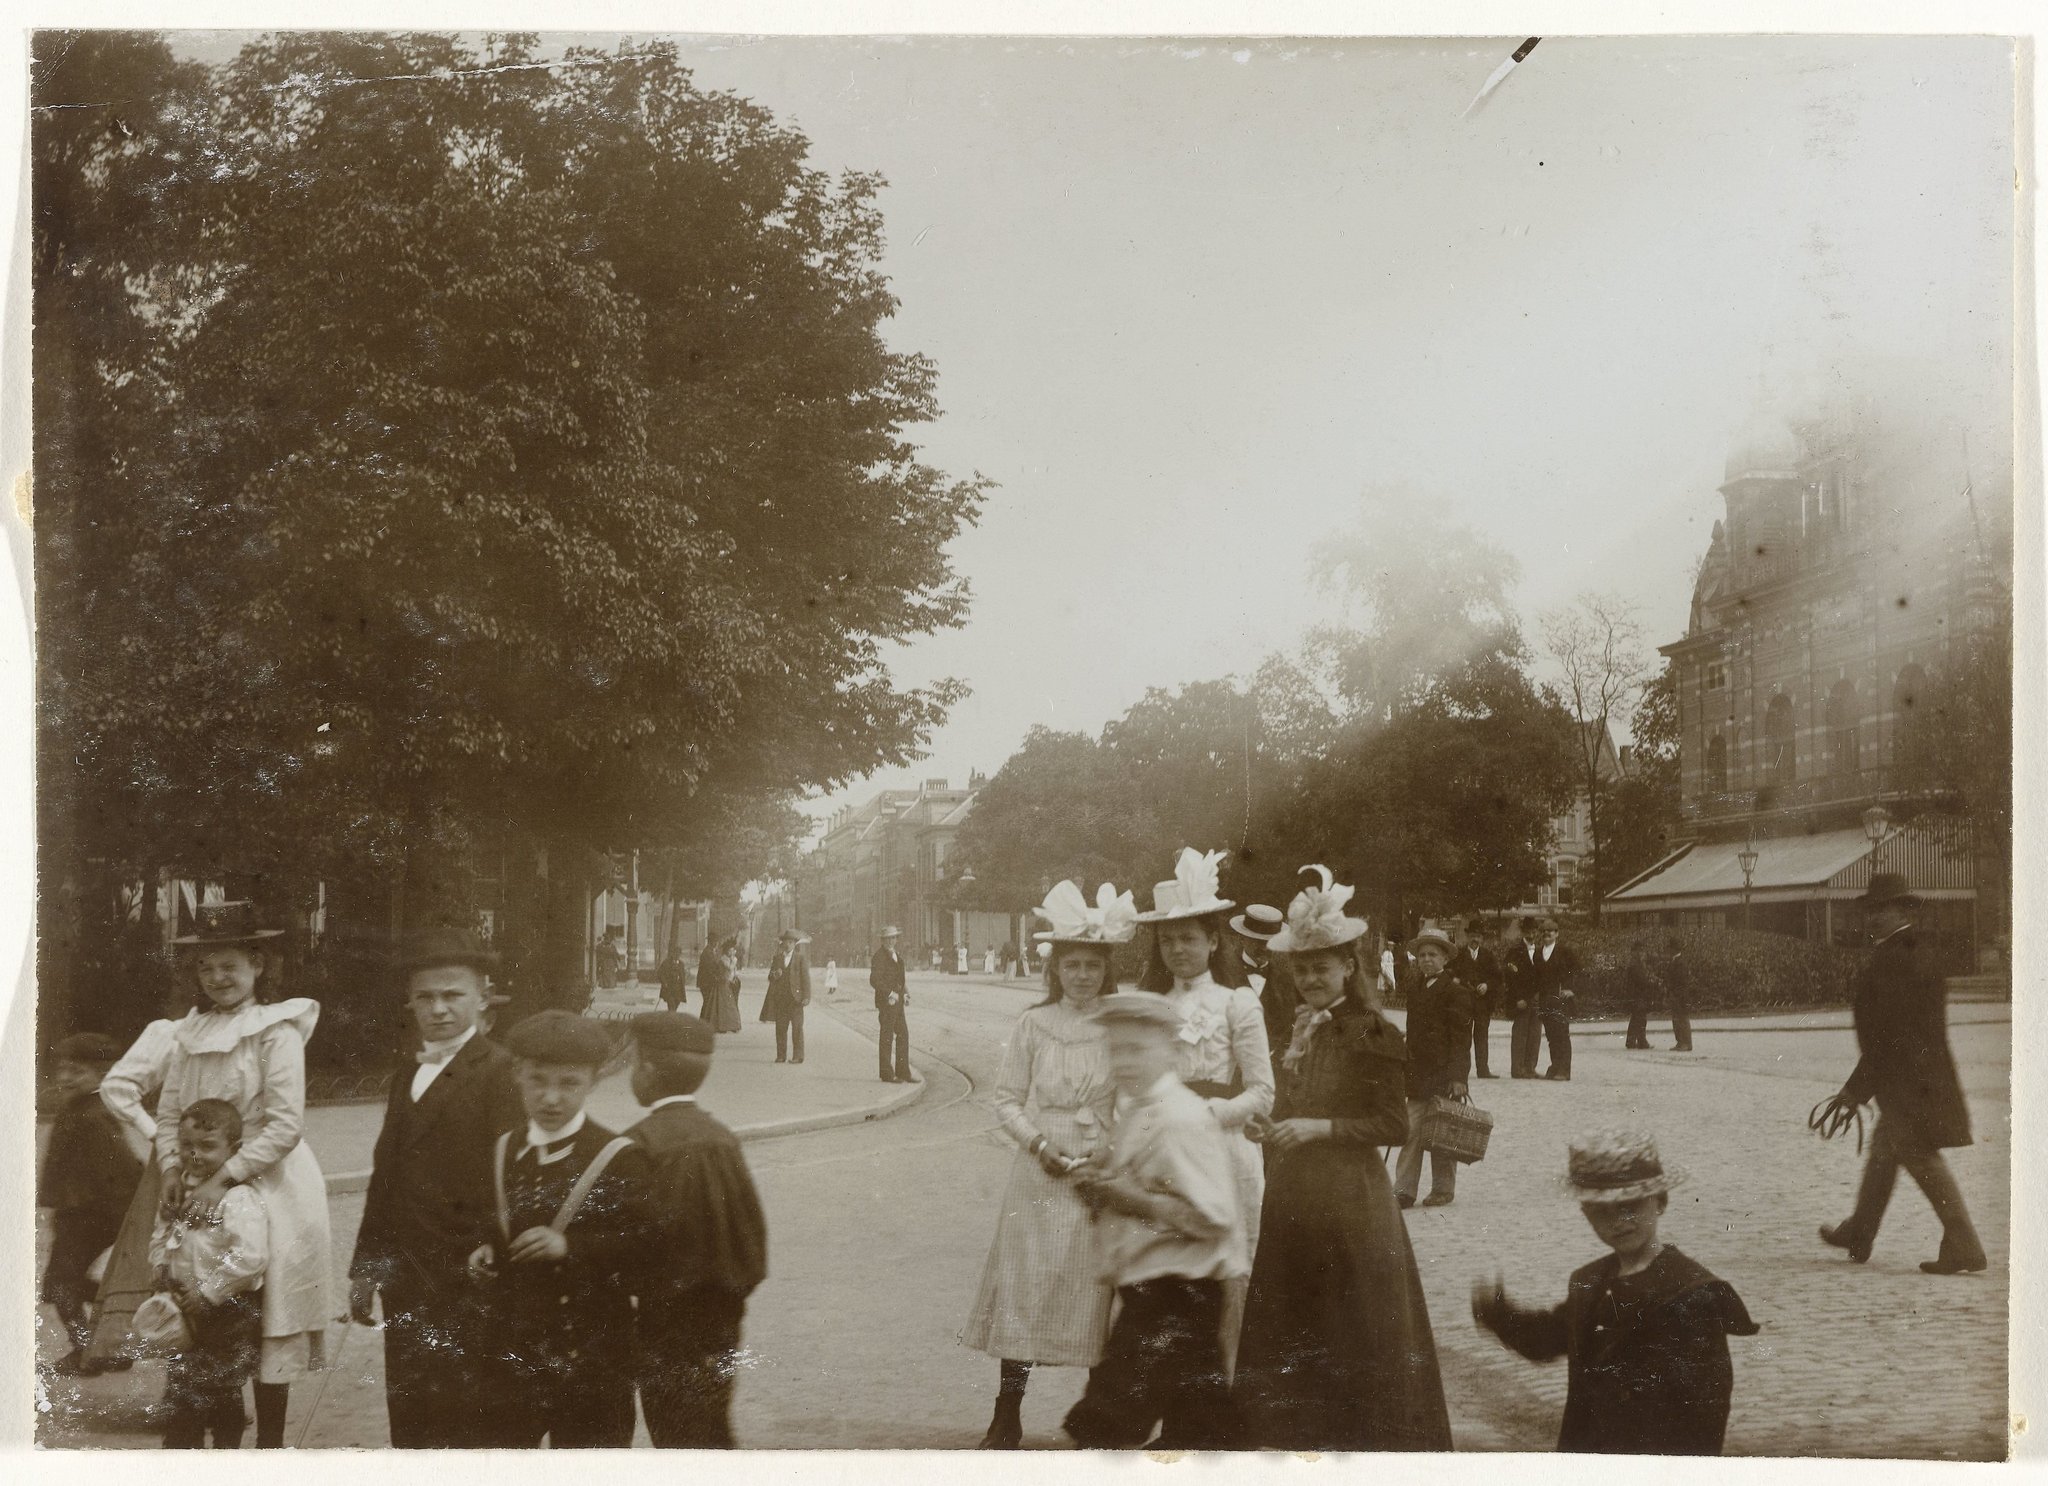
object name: photograph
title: Mensen op het Velperplein in Arnhem, rechts het Musis Sacrum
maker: Anonymous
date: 1900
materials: paper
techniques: collodion silver print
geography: arnhem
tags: square, place, circus, etc.